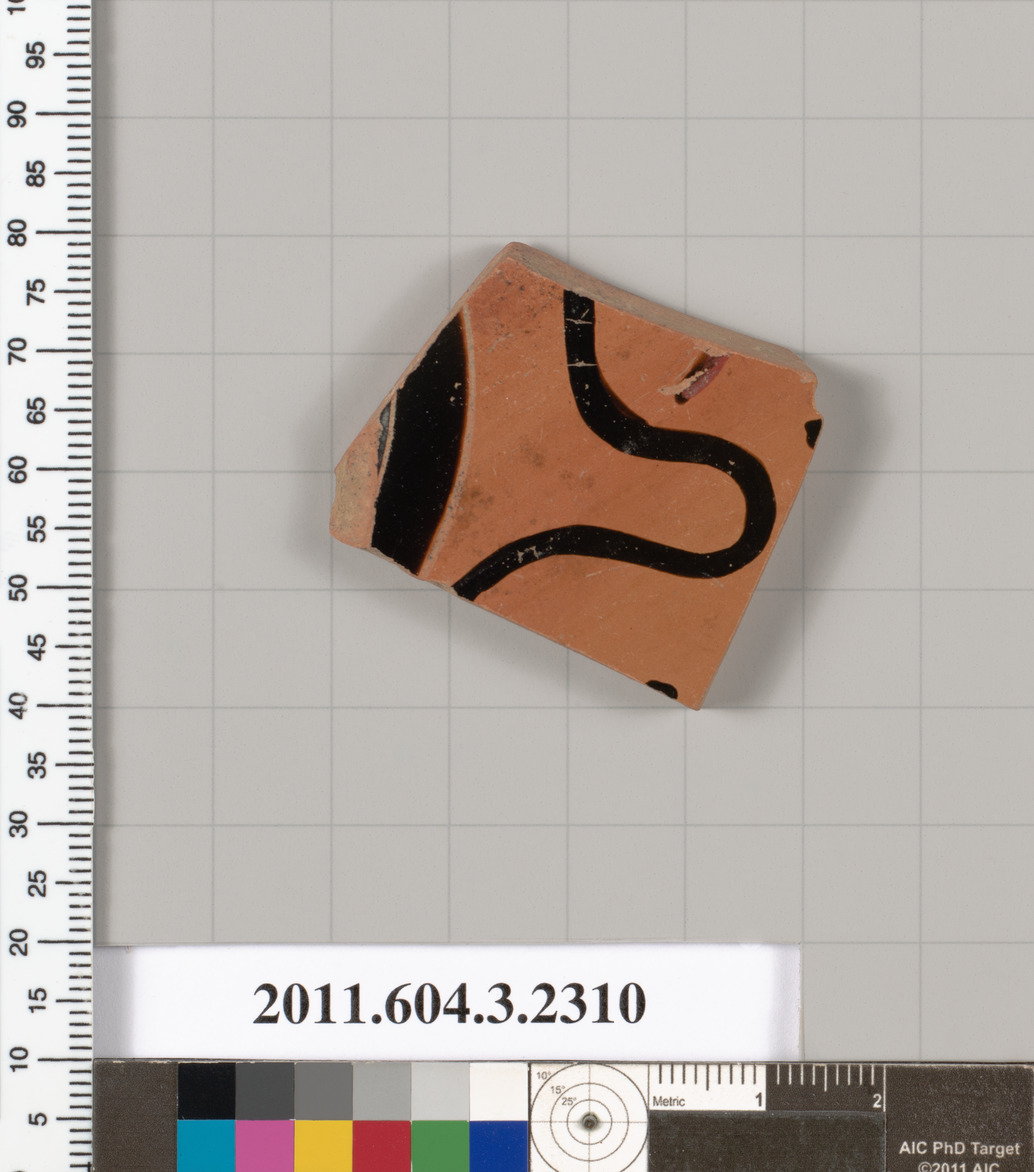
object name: kylix fragment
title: Terracotta fragment of a kylix: eye-cup (drinking cup)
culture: greek, attic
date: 540-530 BCE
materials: terracotta